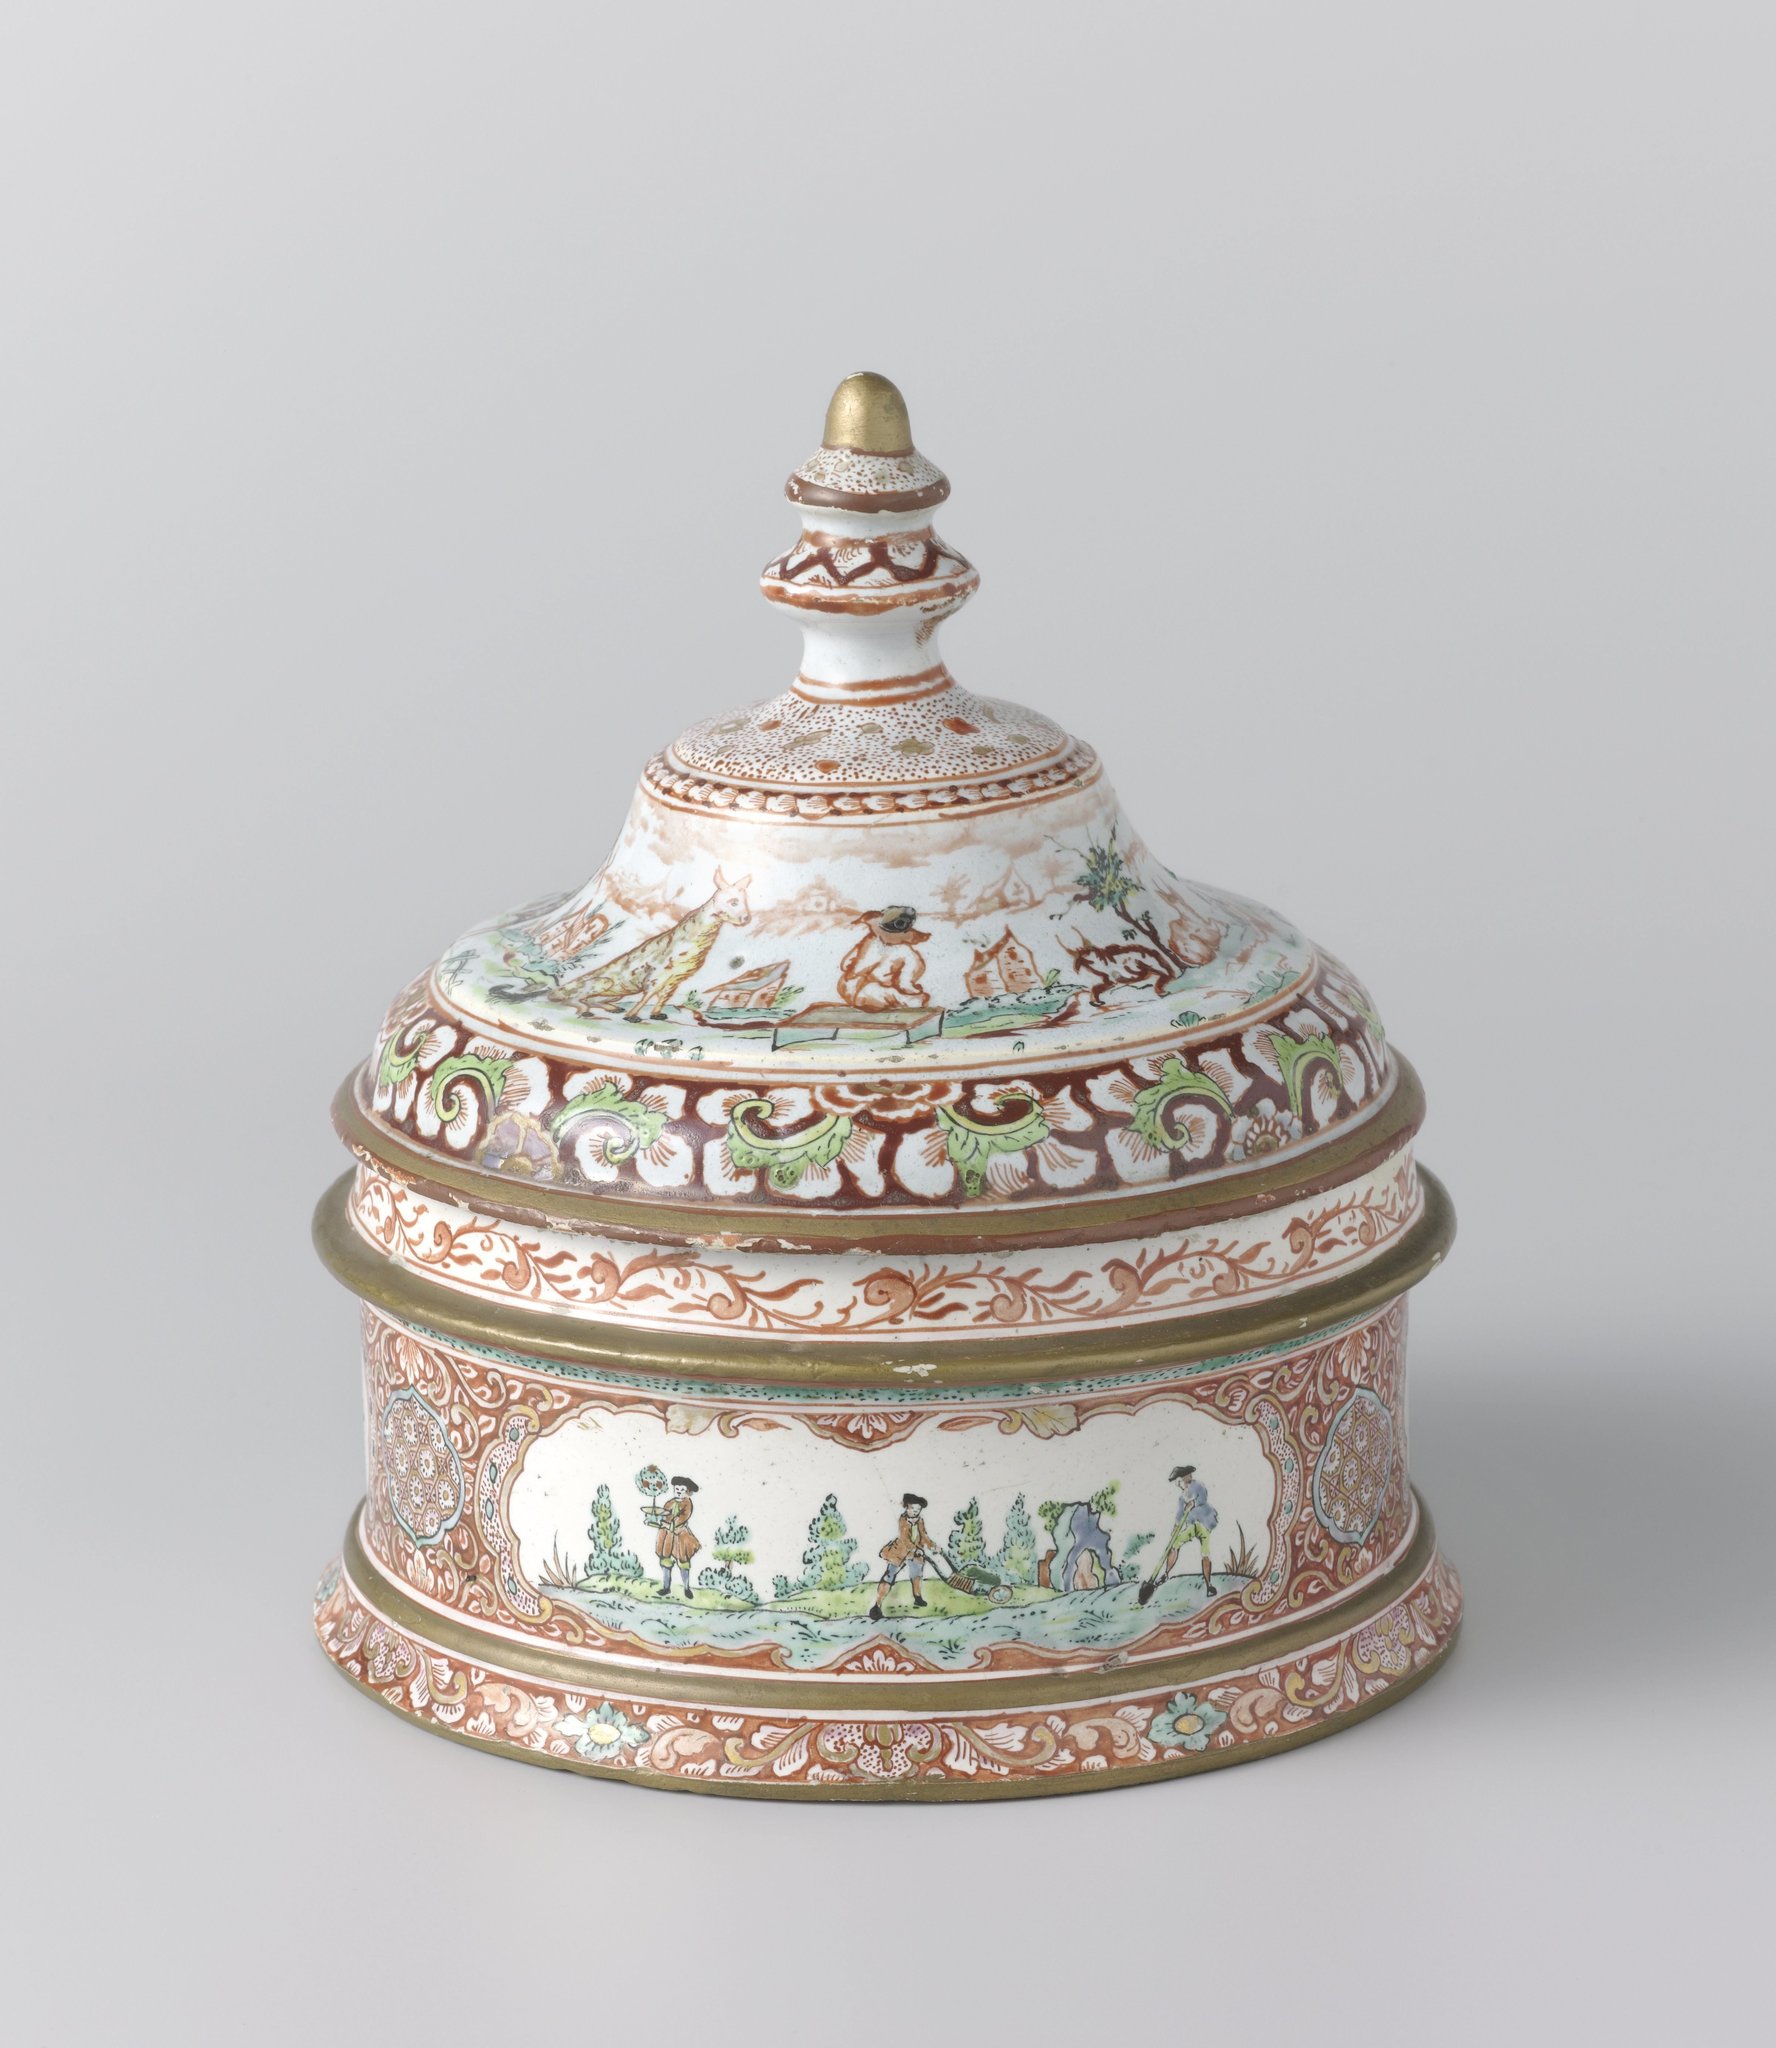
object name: tobacco jar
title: Deksel, veelkleurig beschilderd met een landschap met dieren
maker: Anonymous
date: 1740-1770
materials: faience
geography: delft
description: Lid. Faience. Delft, c. 1740 - 1770. Given by the heirs of John F. Loudon, 1916.